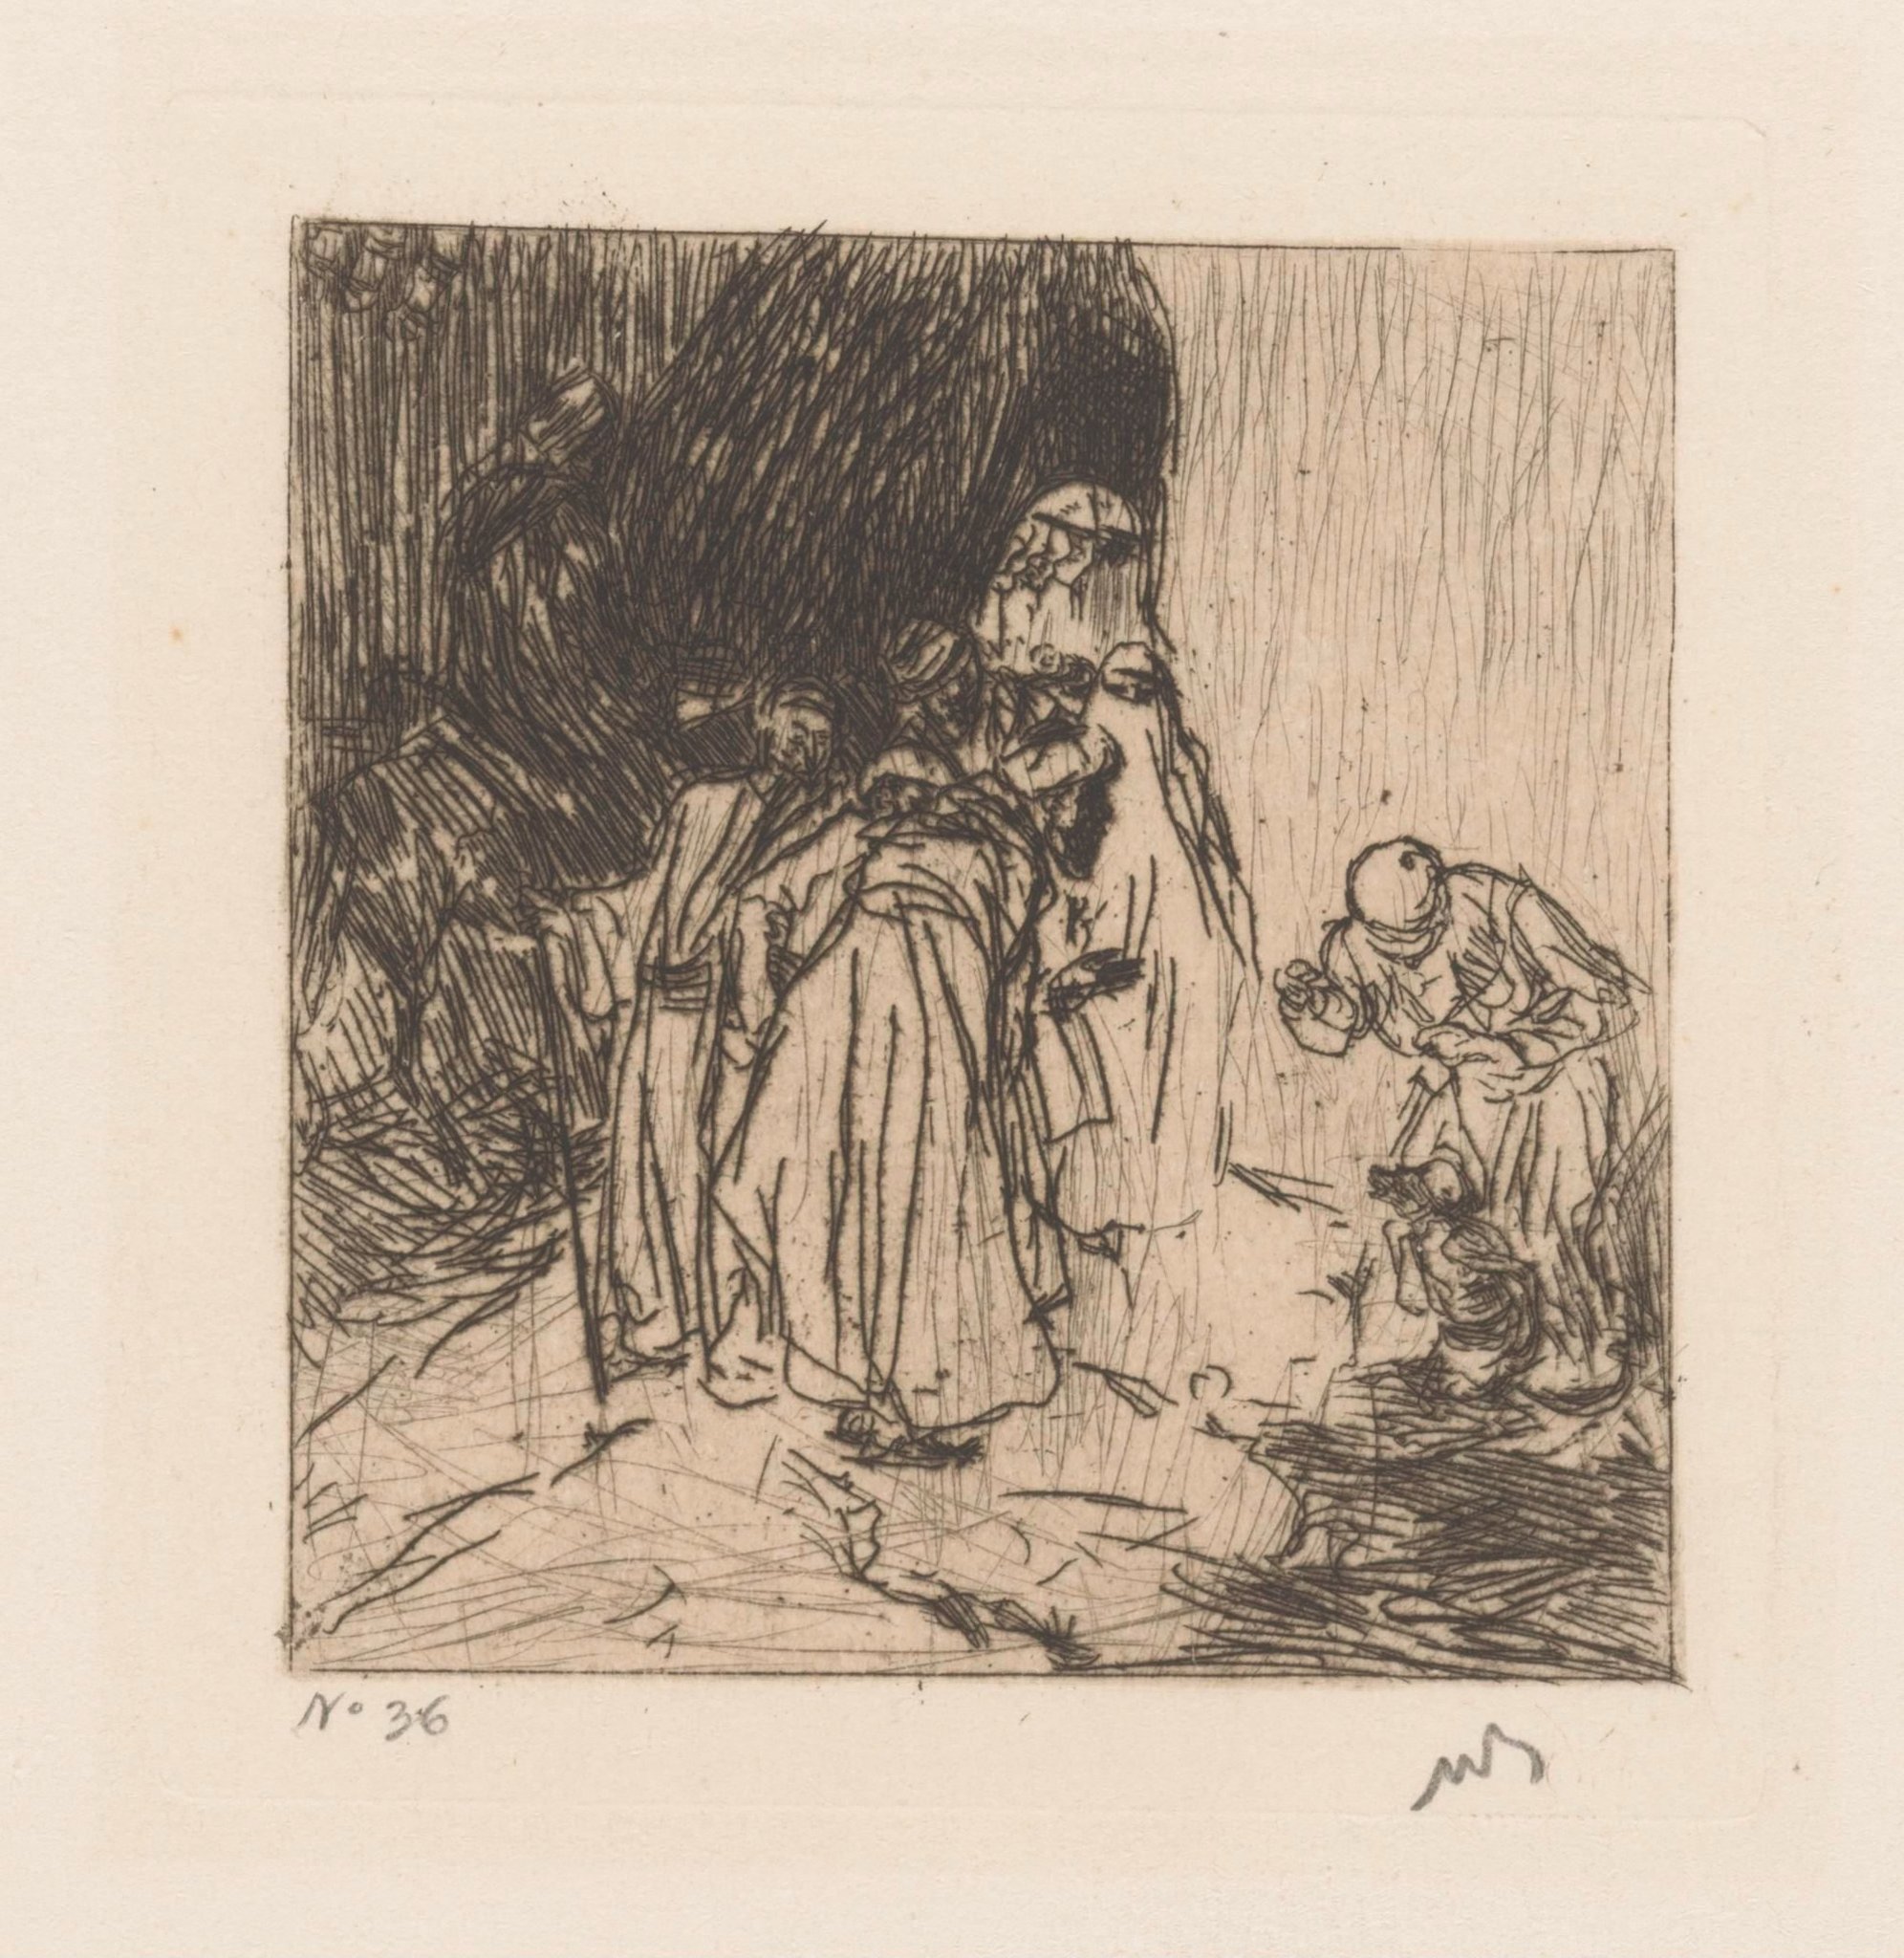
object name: print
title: Dresseur met gedresseerde aap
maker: marius bauer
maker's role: draughtsman, print maker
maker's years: 1867-1932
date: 1888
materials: paper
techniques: etching, intaglio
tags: monkeys, apes, earning money with (performing) animals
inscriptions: collector's mark: Lugt 2760, collector's mark: Lugt 2228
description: Een dresseur geeft op straat een voorstelling met een gedreseerde aap. Mannen en vrouwen in oosterse kleding kijken toe.